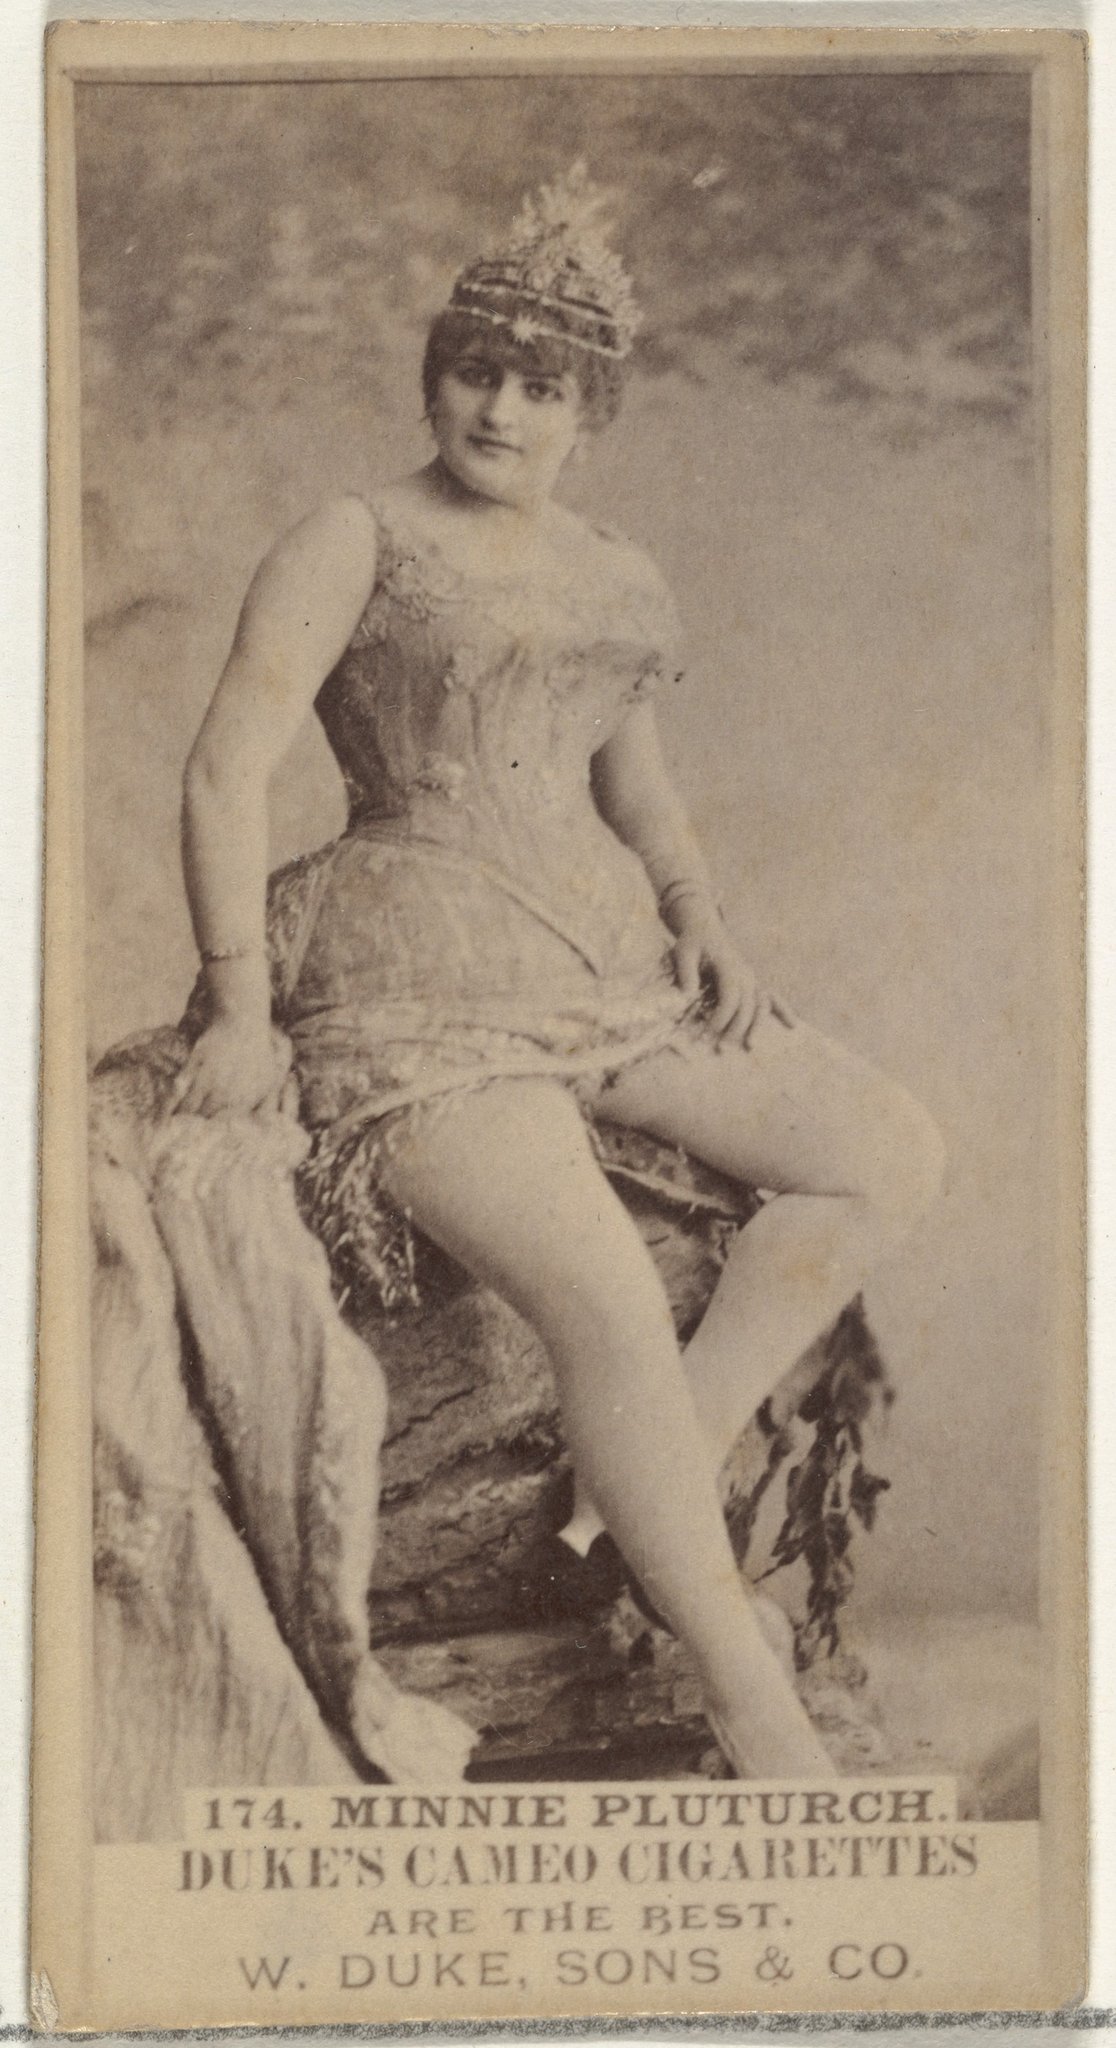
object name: photograph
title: Card Number 174, Minnie Pluturch, from the Actors and Actresses series (N145-5) issued by Duke Sons & Co. to promote Cameo Cigarettes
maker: w. duke, sons & co.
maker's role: publisher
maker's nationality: american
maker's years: 1870-1920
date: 1880-1889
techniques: albumen silver print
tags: portraits,women,actresses